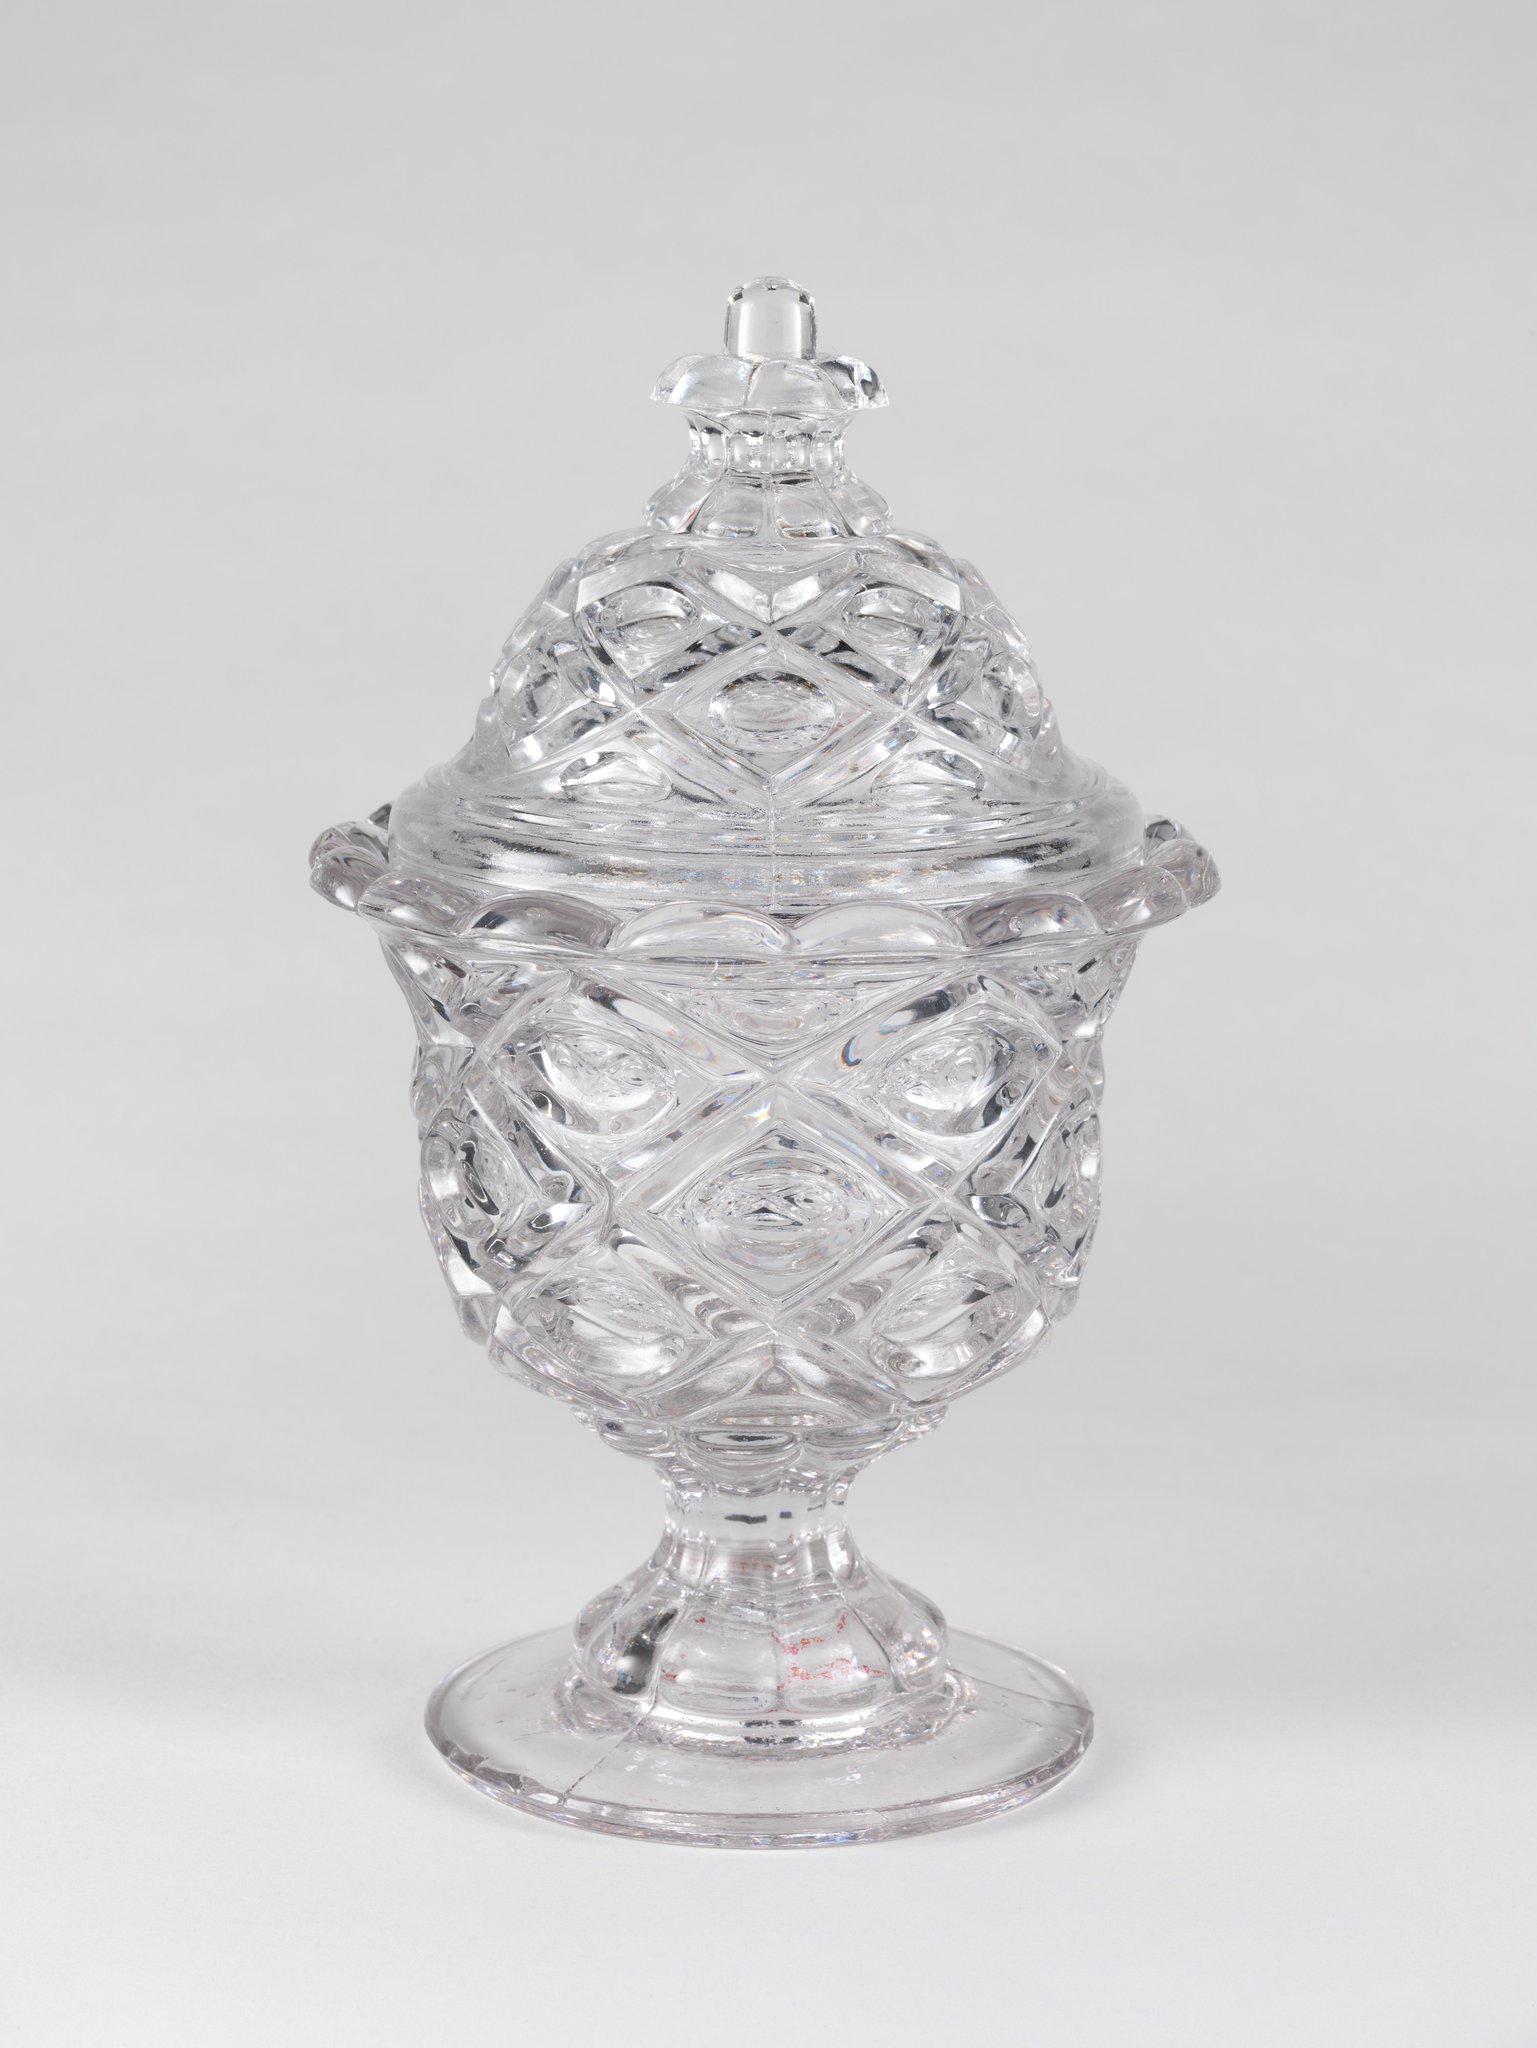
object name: sweetmeat jar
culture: american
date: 1850-1870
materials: diamond, glass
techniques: pressed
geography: united states